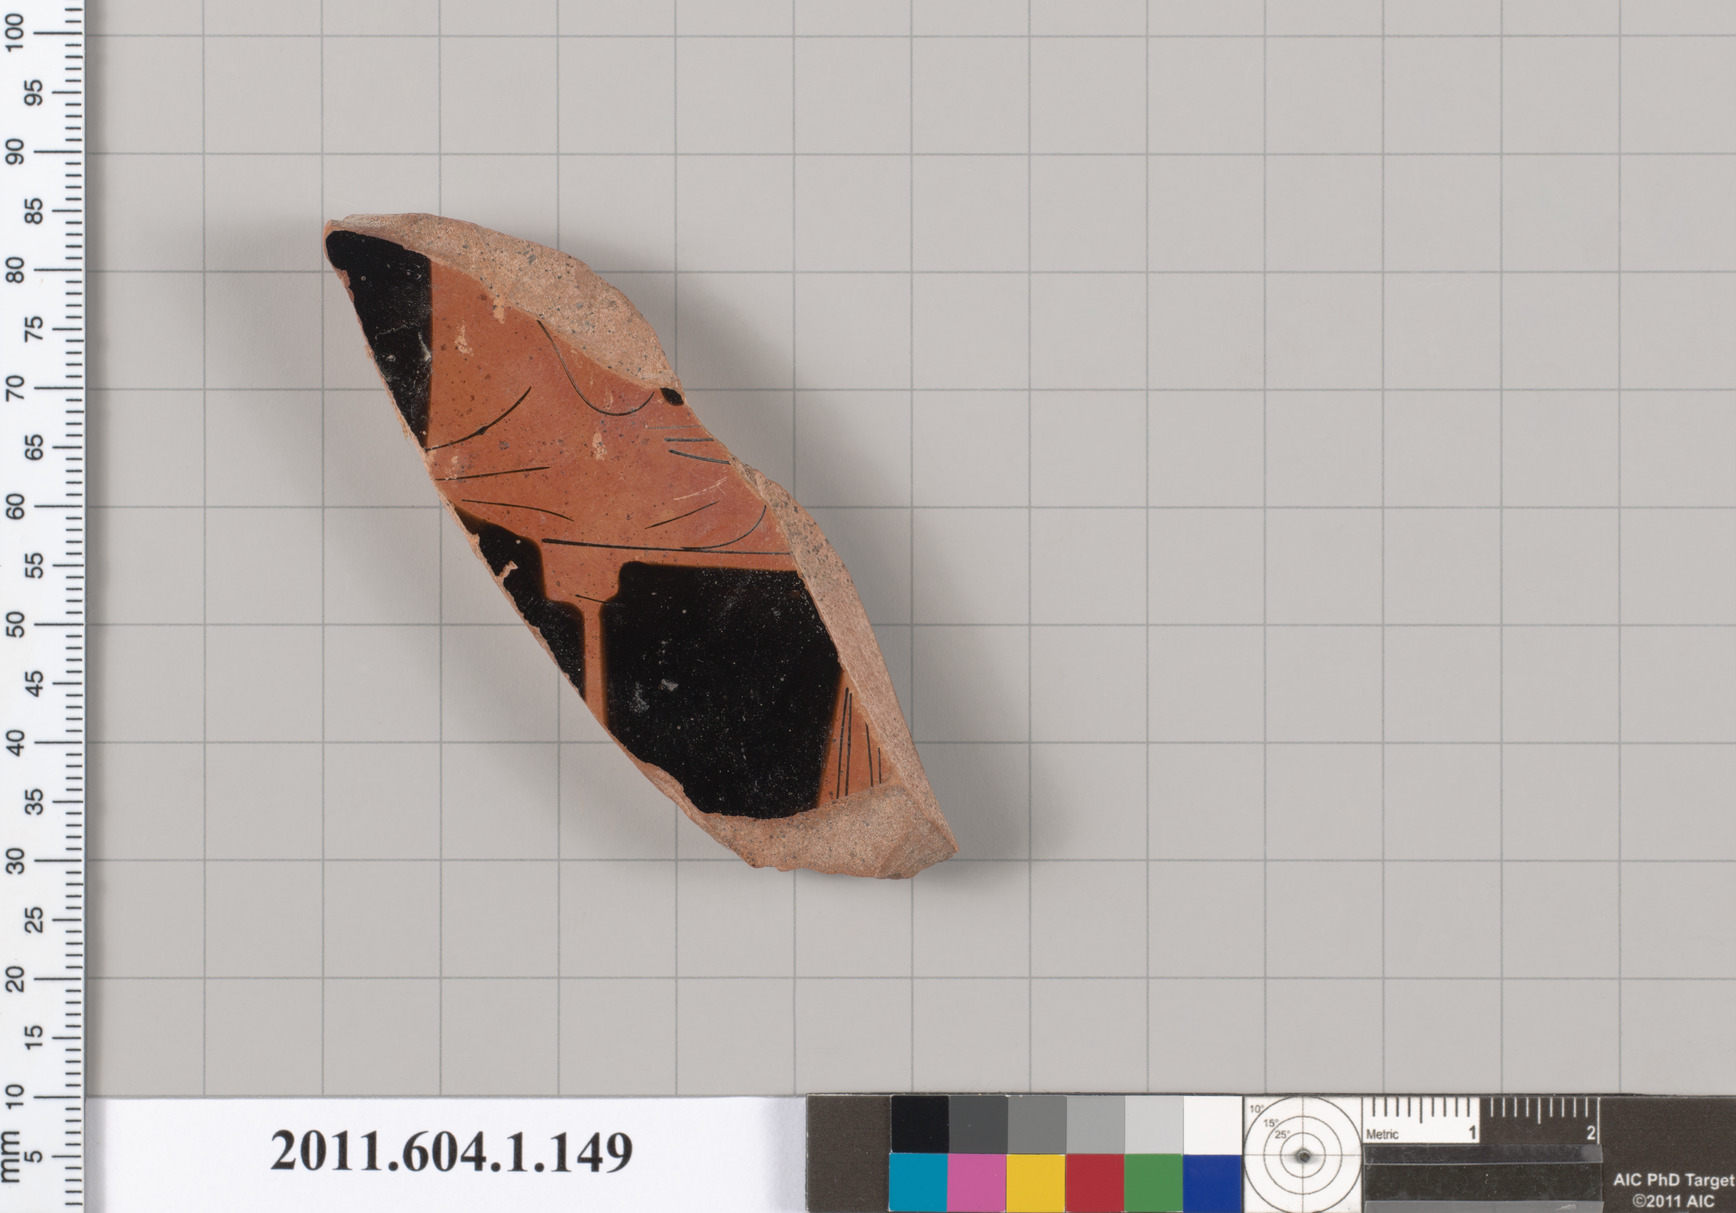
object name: kylix fragment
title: Terracotta fragment of a kylix (drinking cup)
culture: greek, attic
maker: painter of bologna 417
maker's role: artist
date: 475-451 BCE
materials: terracotta